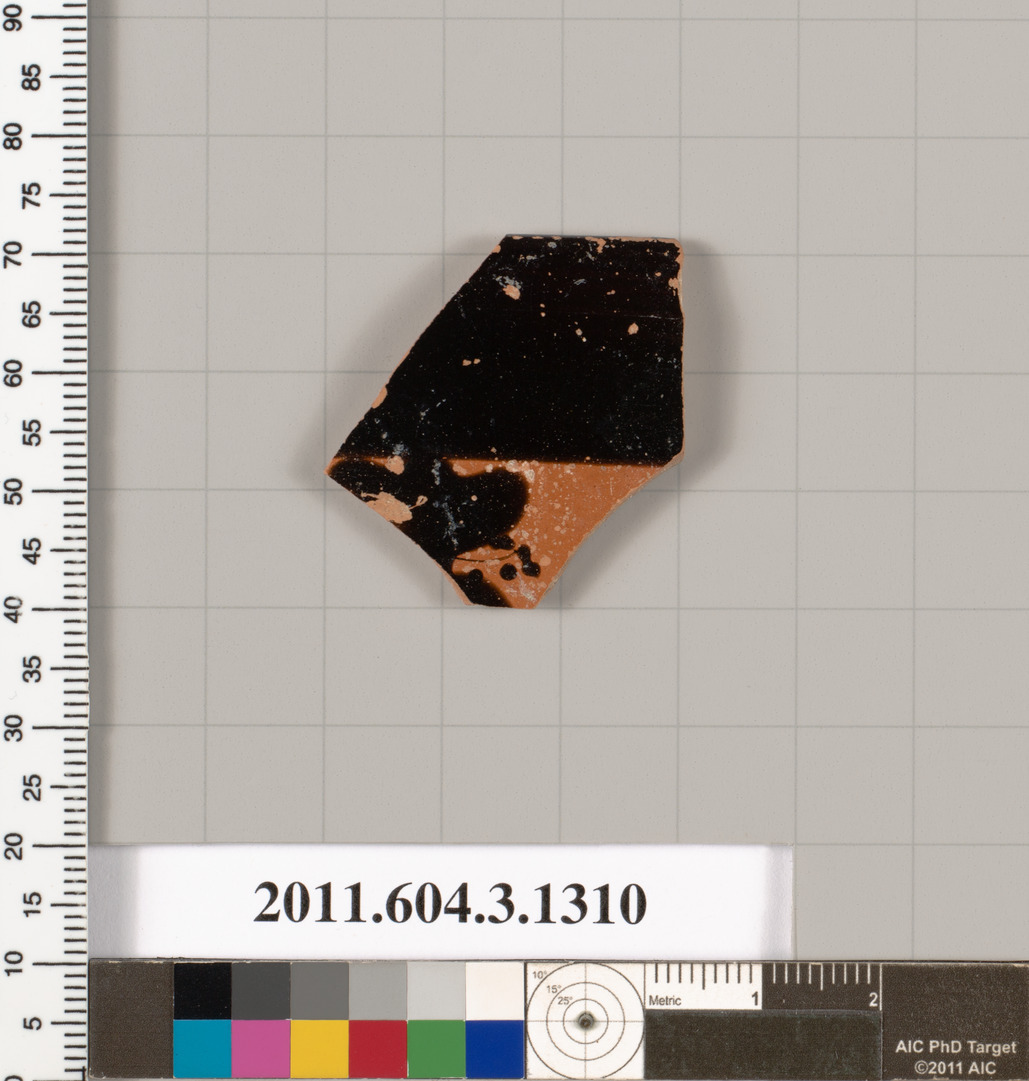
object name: skyphos fragment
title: Terracotta rim fragment of a skyphos (deep drinking cup)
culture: greek, attic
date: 490-480 BCE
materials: terracotta